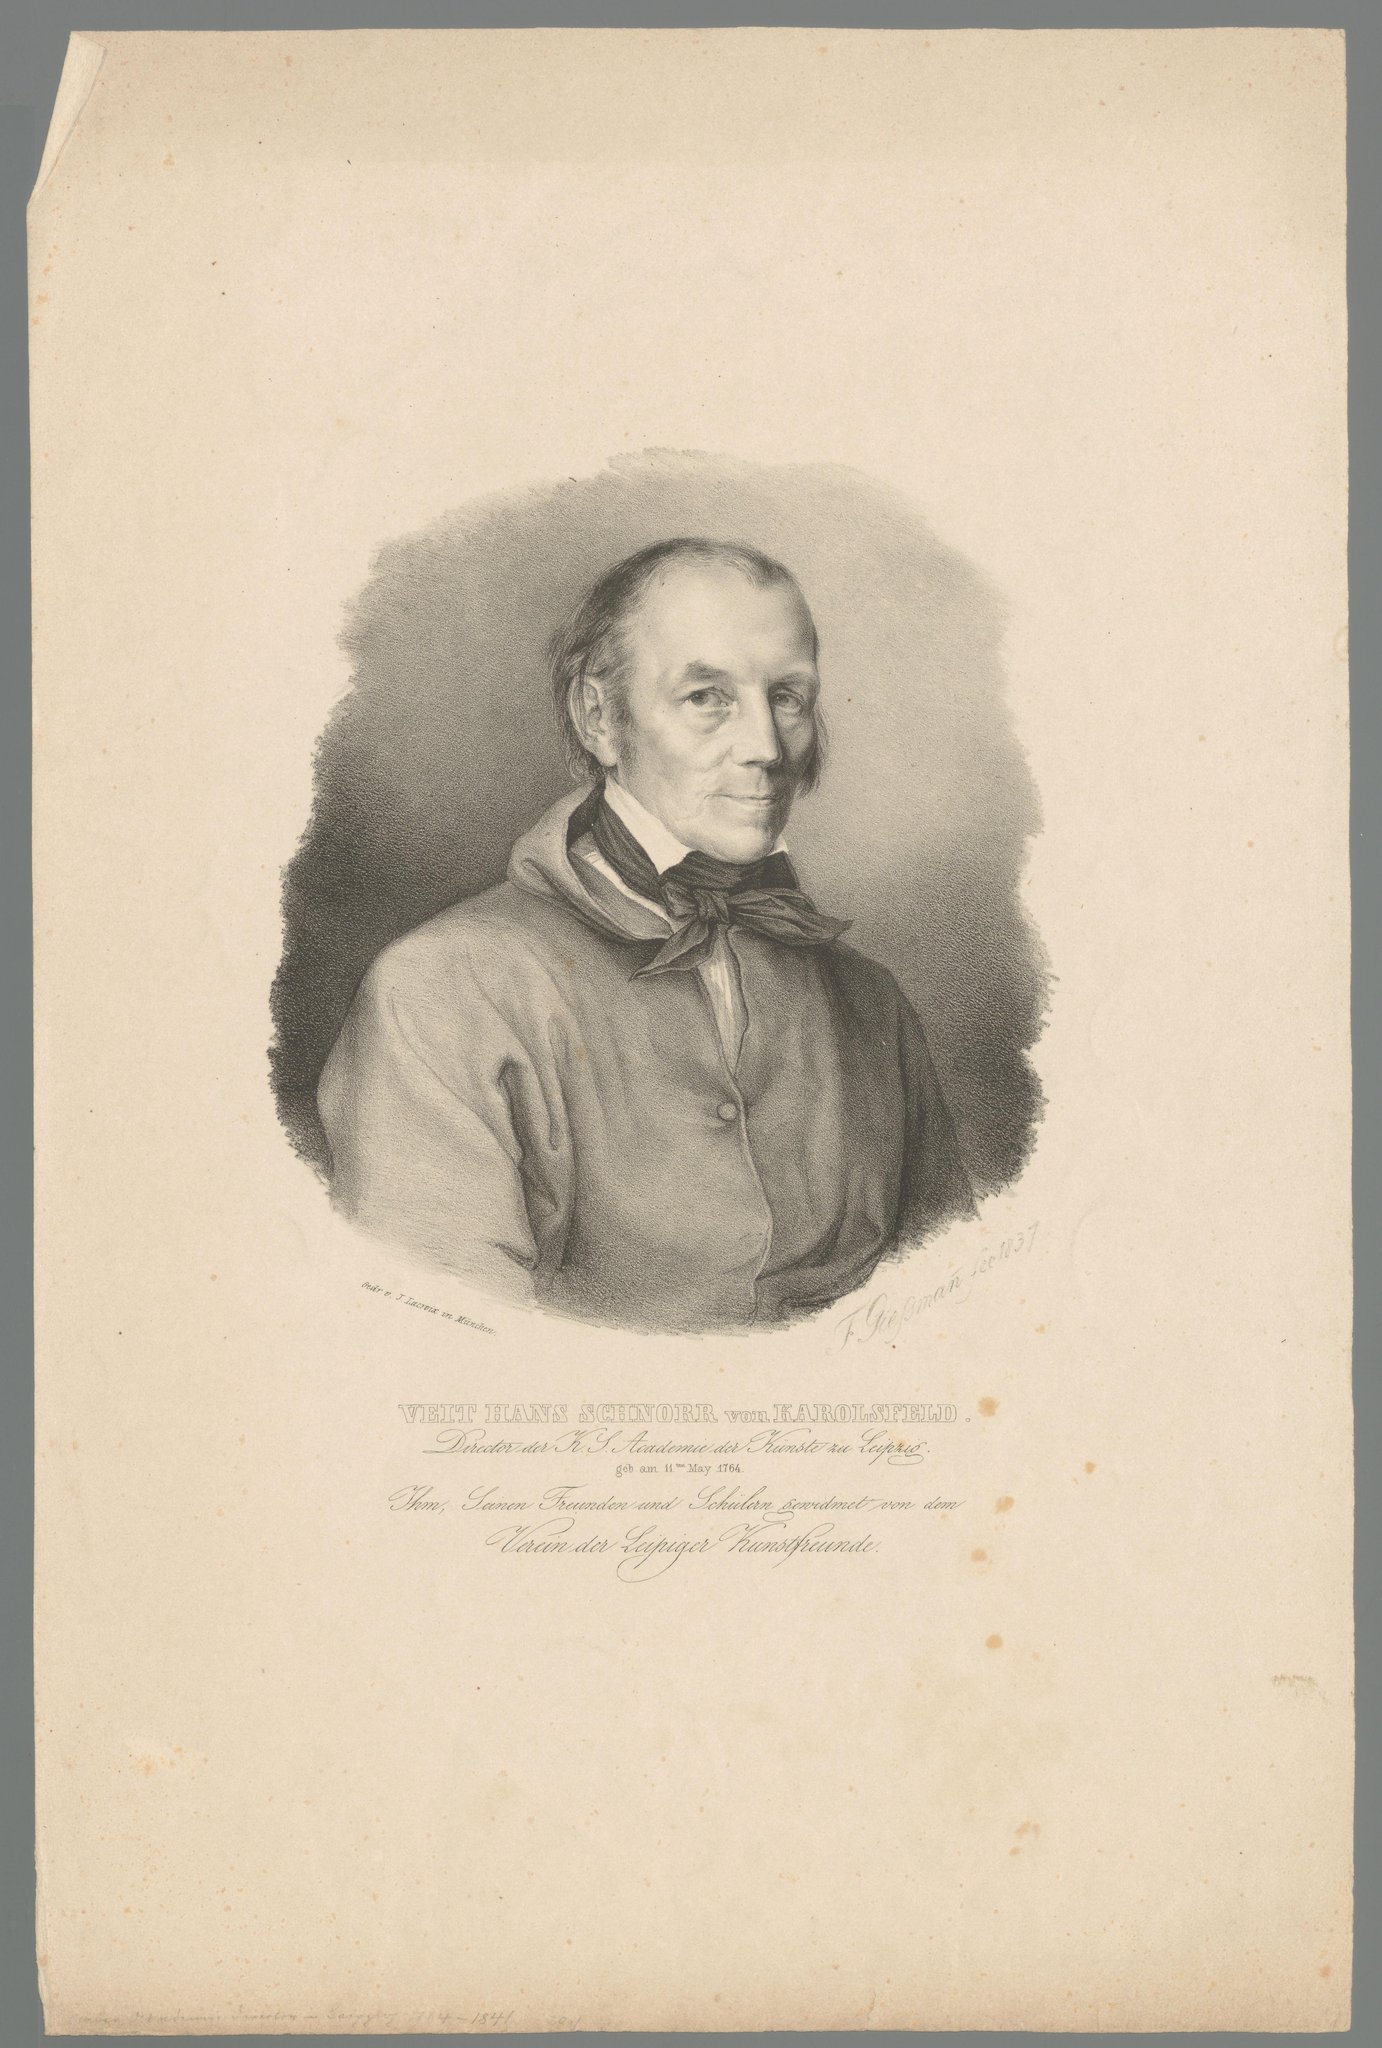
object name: print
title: Portret van Hans Veit Friedrich Schnorr von Carolsfeld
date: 1837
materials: paper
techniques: lithograph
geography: munich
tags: painter, hans veit friedrich schnorr von carolsfeld, adult man, historical persons, portrait, self-portrait of painter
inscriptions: collector's mark: Lugt 2228